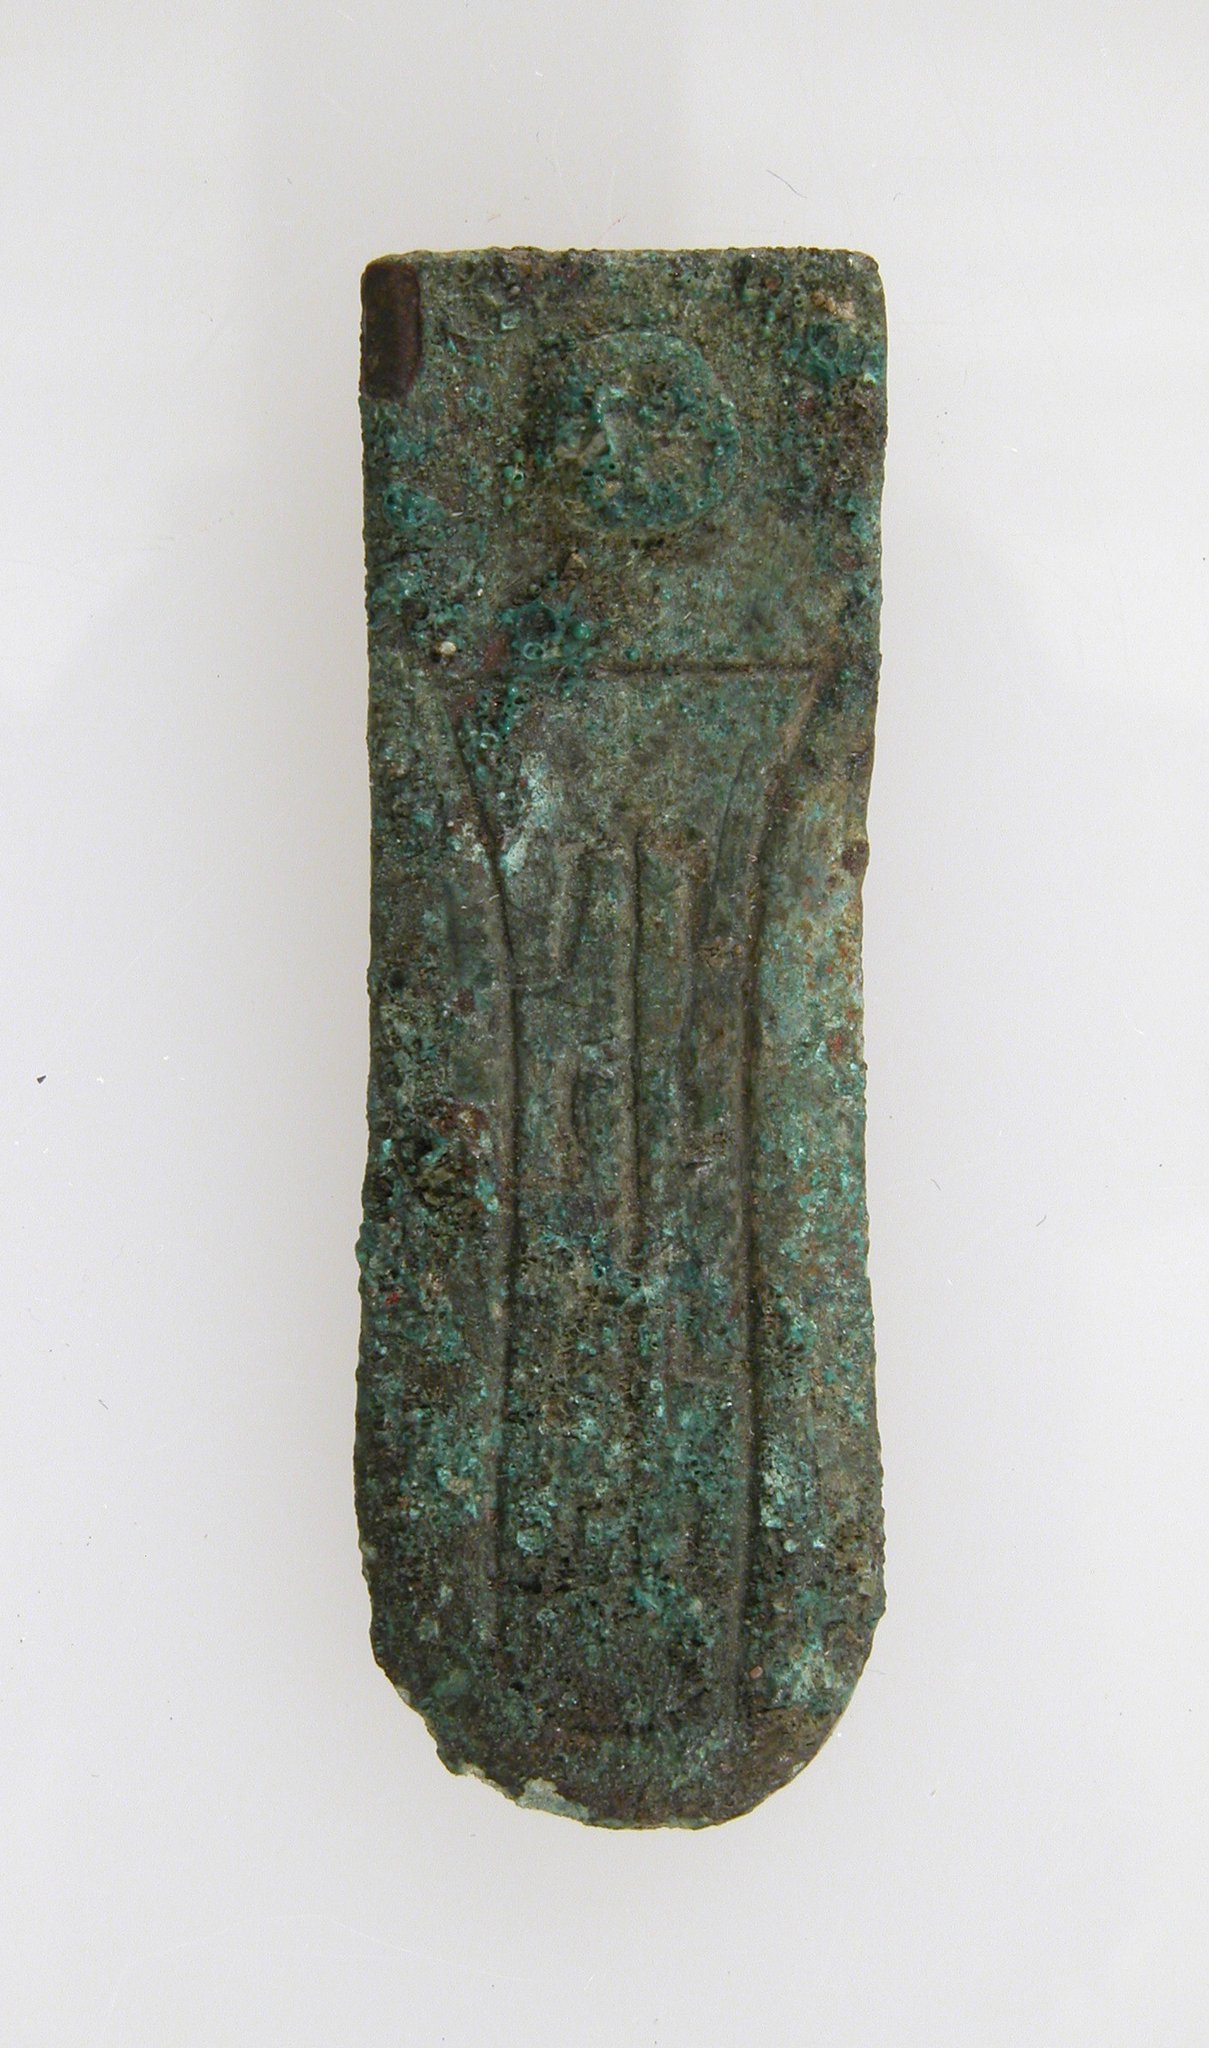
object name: ferret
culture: frankish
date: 501-700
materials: copper alloy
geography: germany